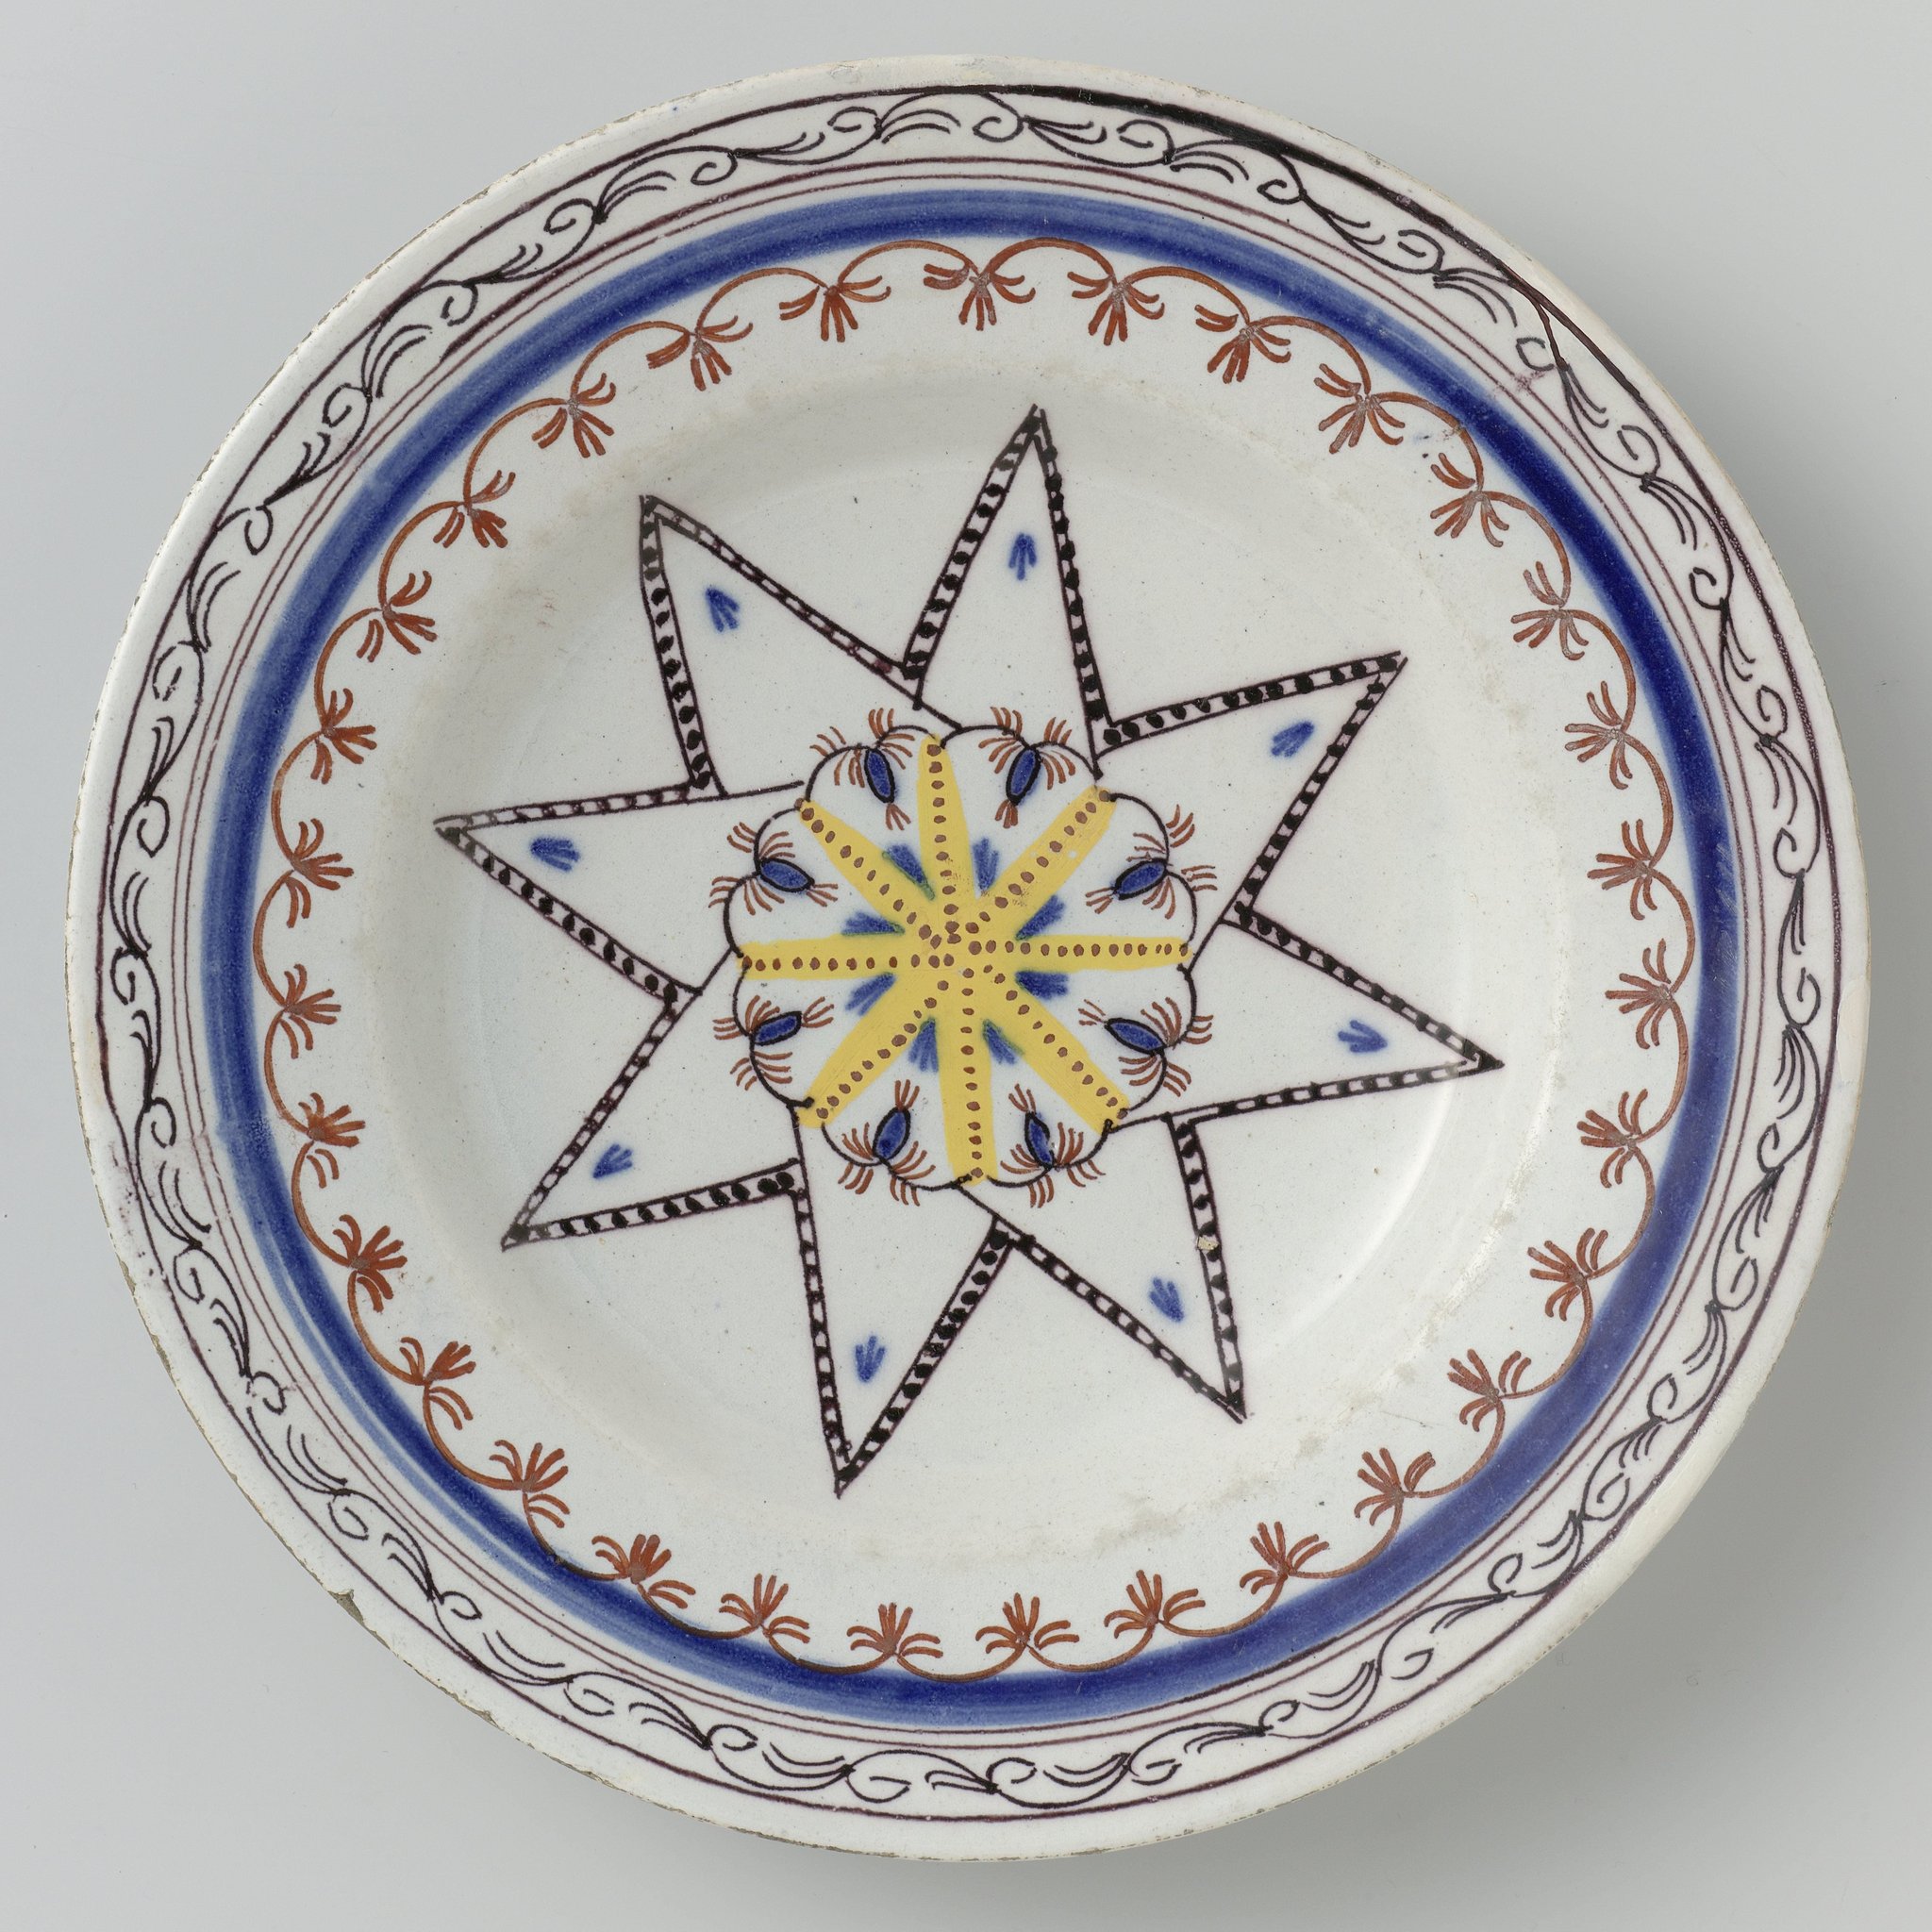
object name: plate dish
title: Bord van faience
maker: Anonymous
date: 1770-1800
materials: faience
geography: delft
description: Bord van faience. Veelkleurig beschilderd met een ster en gedecoreerde randen.